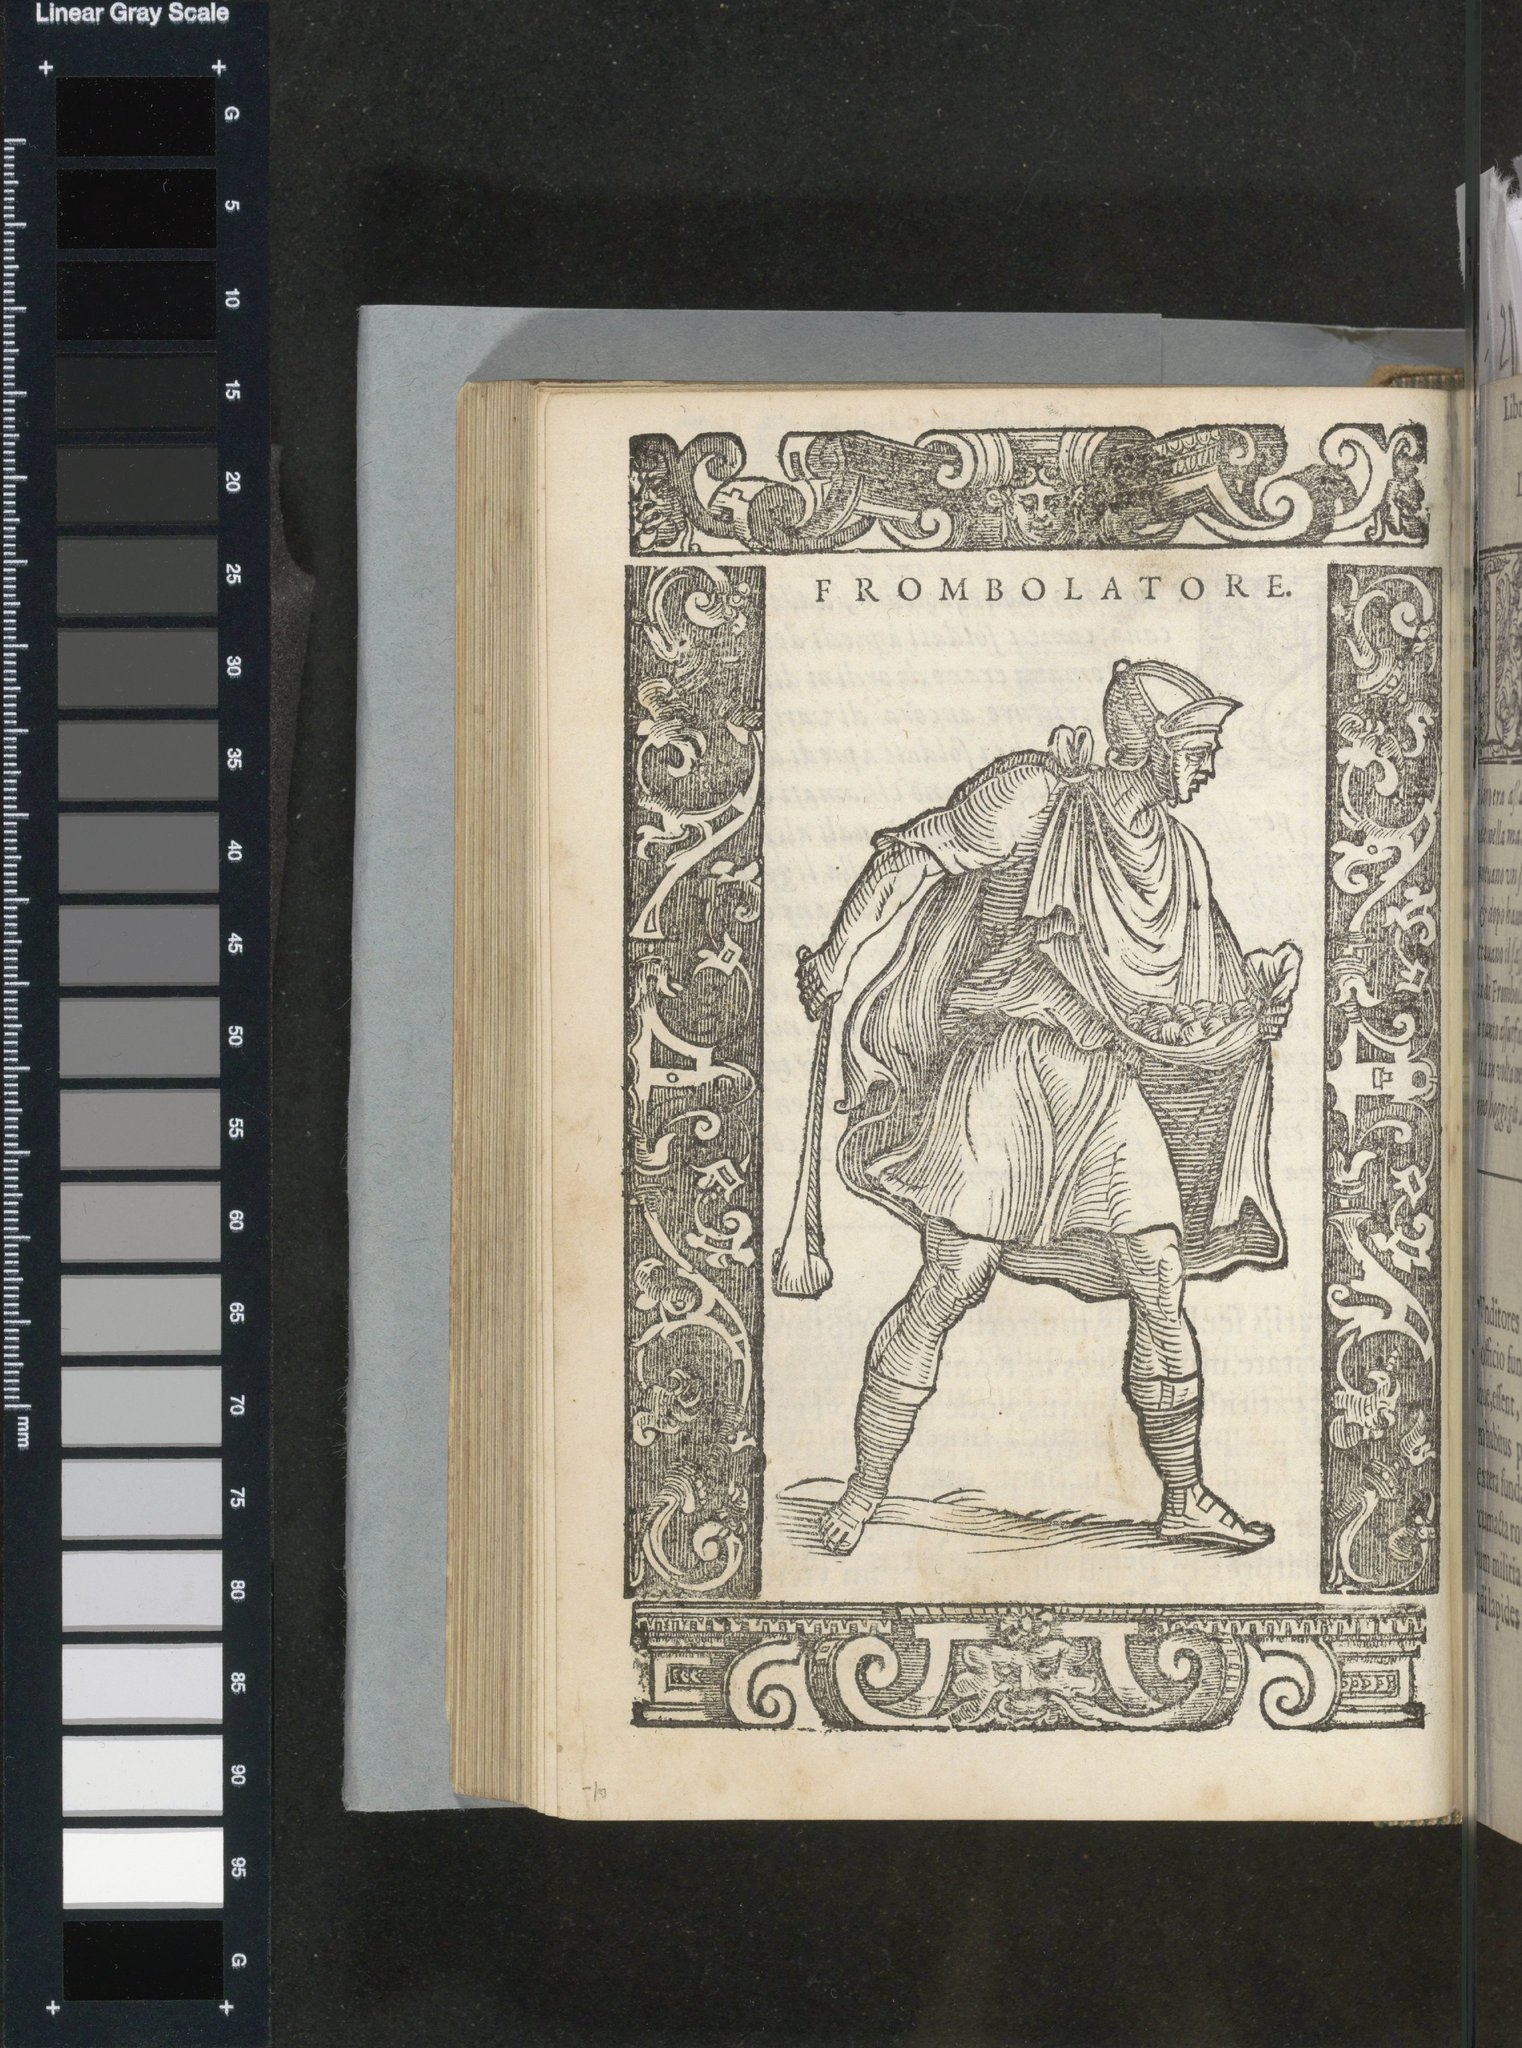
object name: costume print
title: Romeins soldaat met slinger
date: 1598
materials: paper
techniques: woodcut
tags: private soldier, casting weapons: sling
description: Romeins slingerwerper, slinger in de hand, stenen in een doek. In ornamentrand